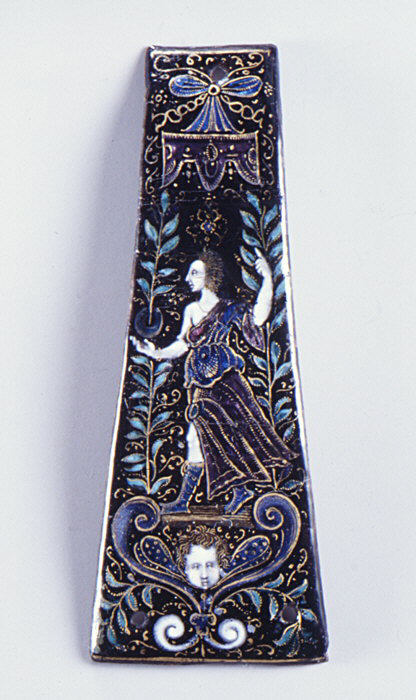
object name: stirrup ornament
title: Luna or Diana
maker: joseph limosin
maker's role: enameler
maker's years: 1675-1775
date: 1601-1625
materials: copper, enamel, gilt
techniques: painting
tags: human figures